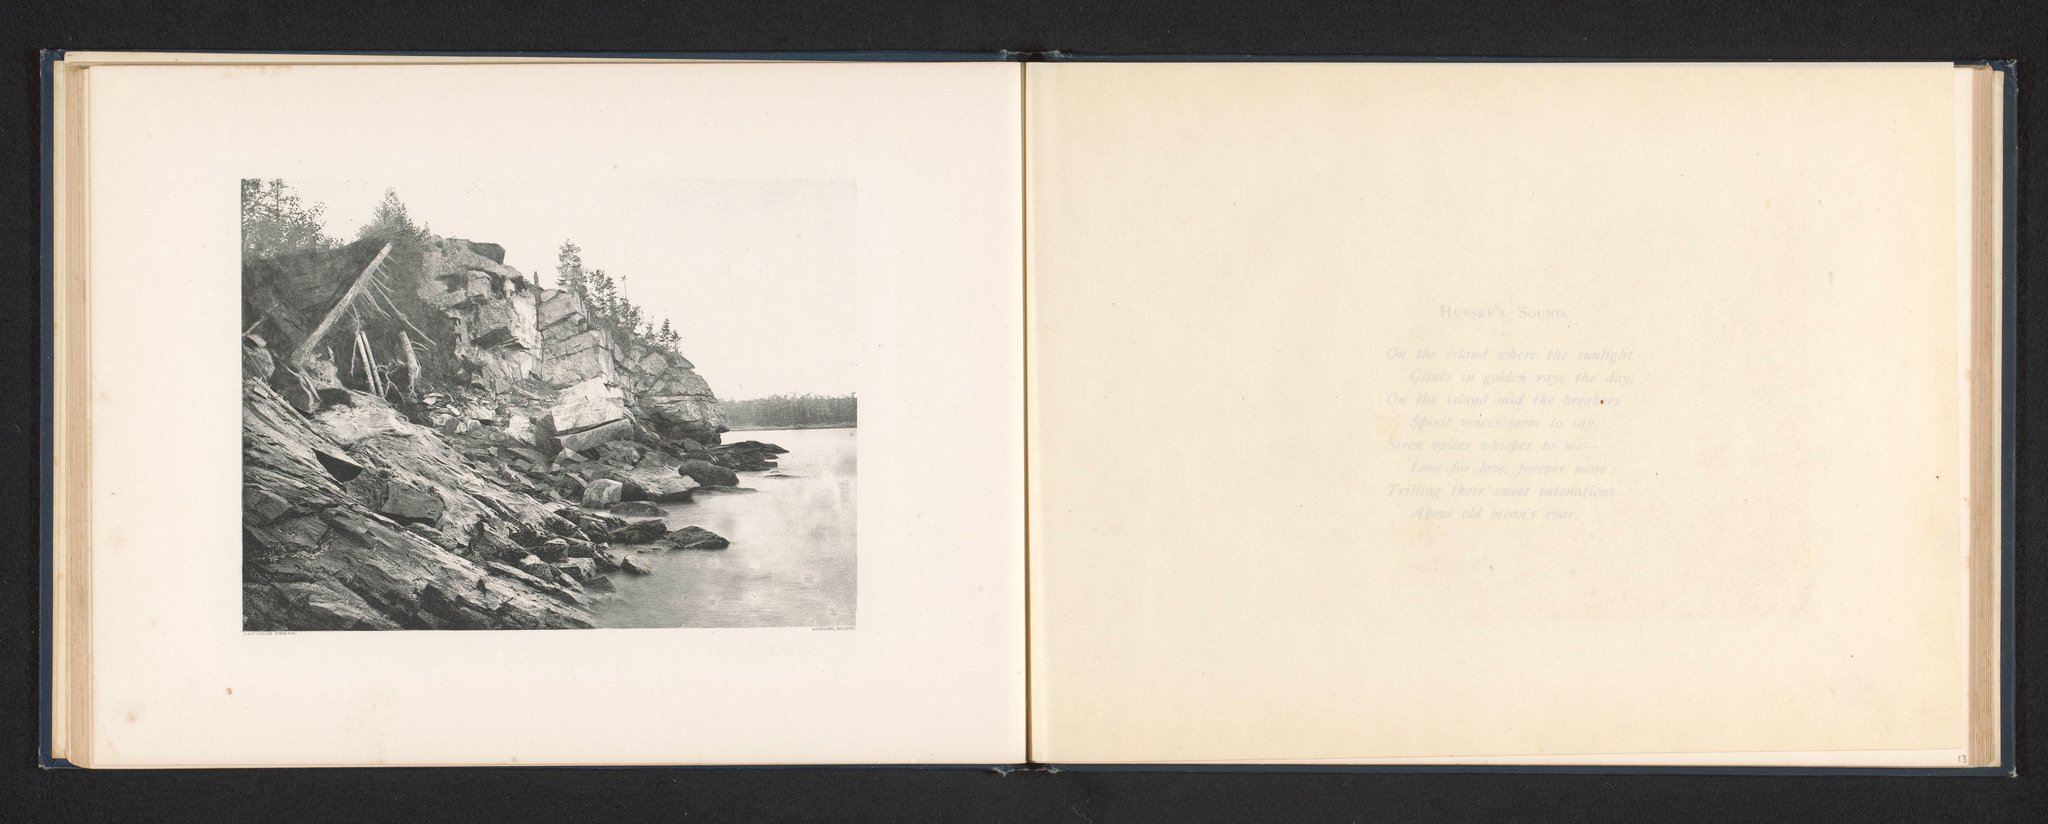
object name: photomechanical print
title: Gezicht op het eiland Pumpkin Knob en de baai Hussey Sound voor de kust van Maine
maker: Anonymous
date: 1880-1890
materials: paper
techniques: photoaquatint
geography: maine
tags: gulf, bay, island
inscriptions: inscription: ‘Hussey Sound. (...)’